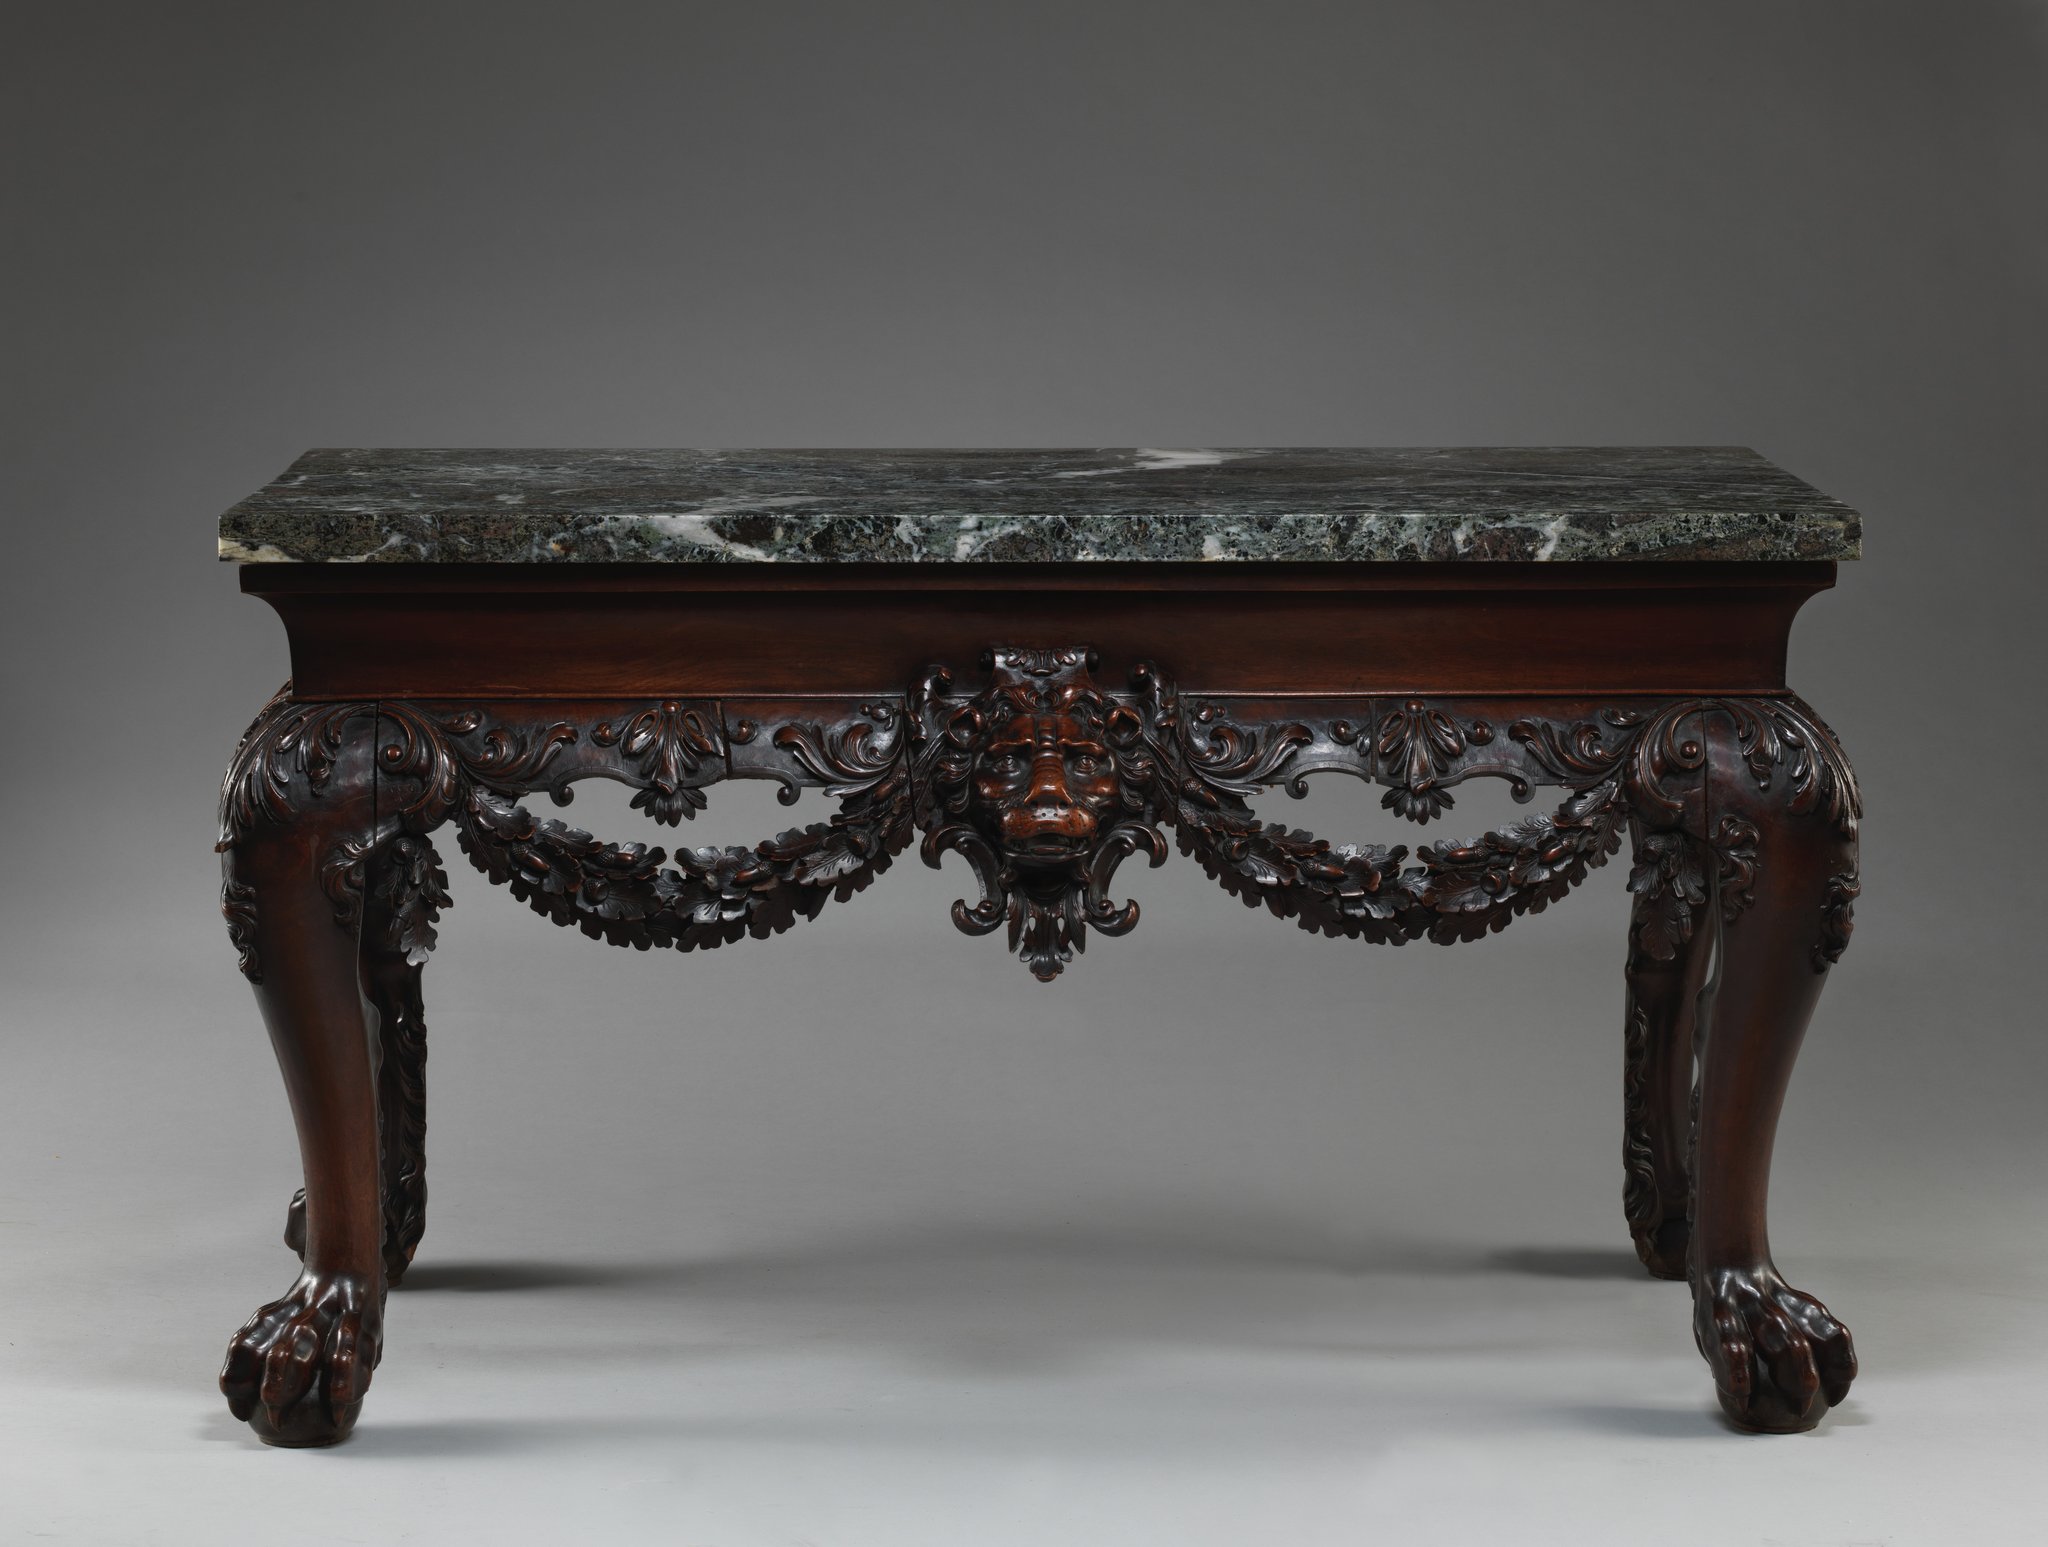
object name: side table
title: Side table (one of a pair)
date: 1740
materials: wood, marble